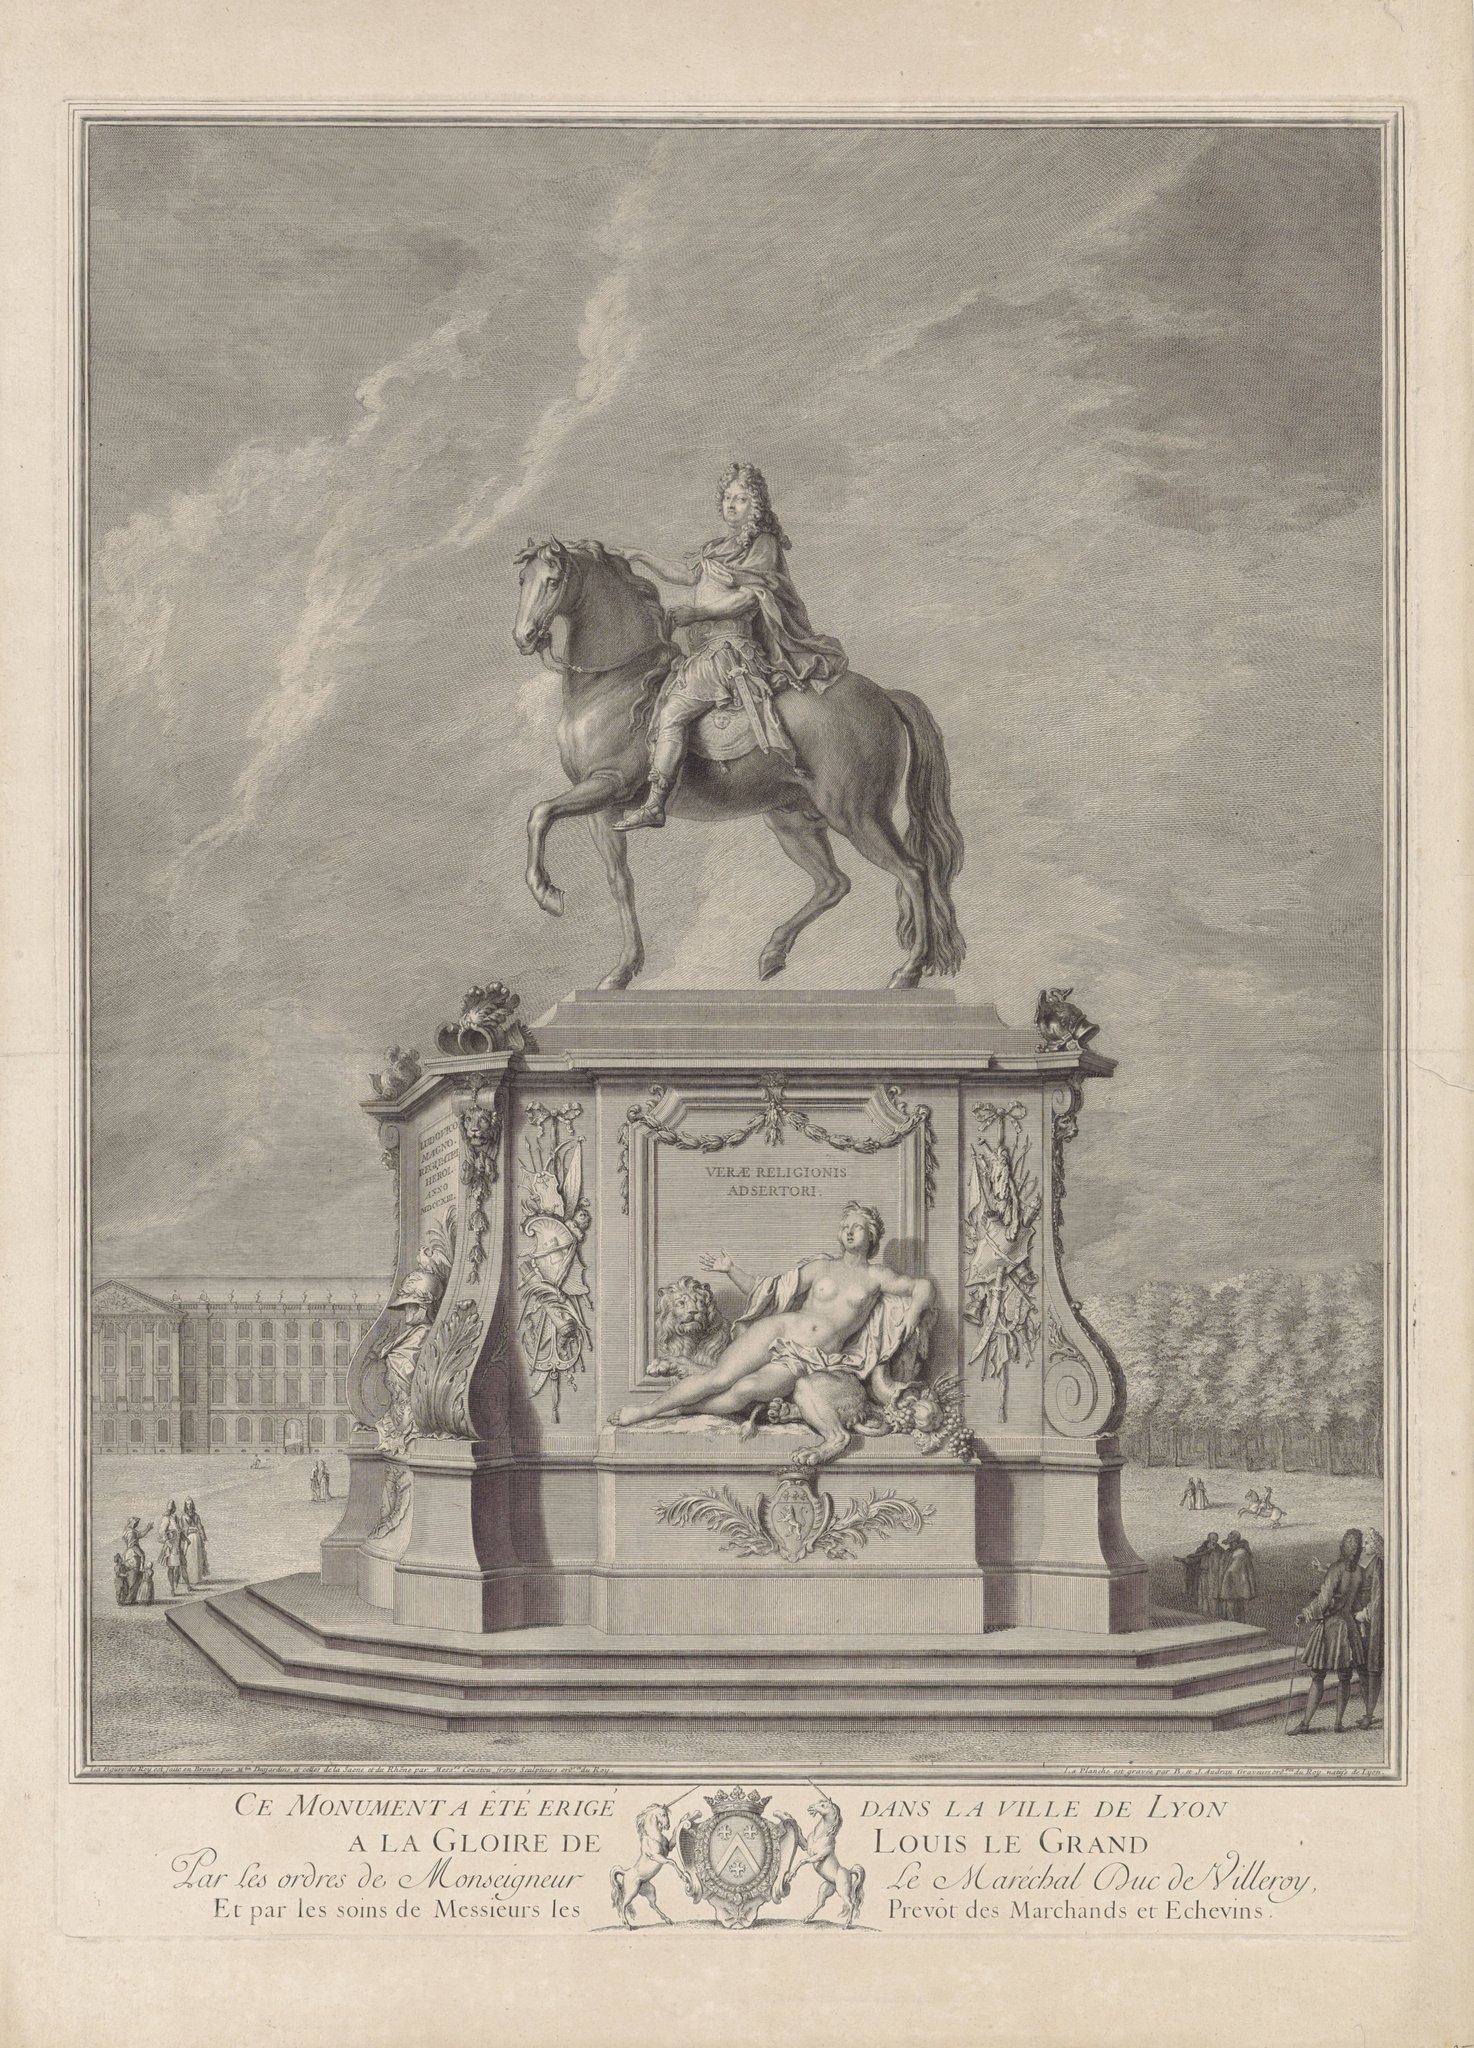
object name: print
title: Standbeeld van Lodewijk XIV, koning van Frankrijk, te Lyon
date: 1713-1721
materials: paper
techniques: engraving, etching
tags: lodewijk xiv (koning van frankrijk), equestrian statue, king, armorial bearing, heraldry, lyon